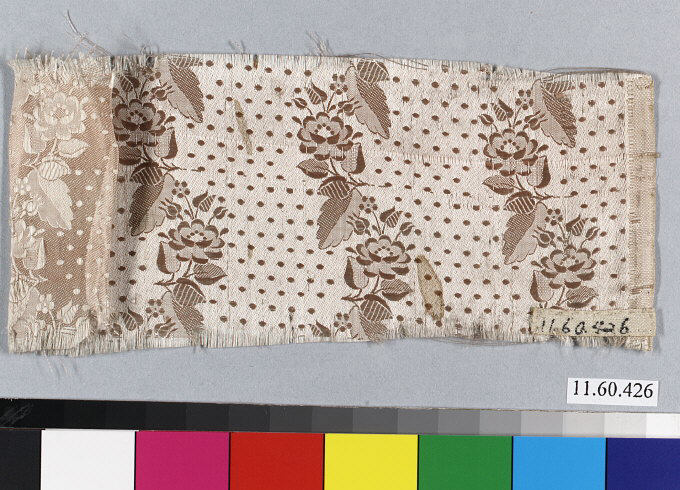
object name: fragment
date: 1801-1900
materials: silk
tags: flowers,leaves